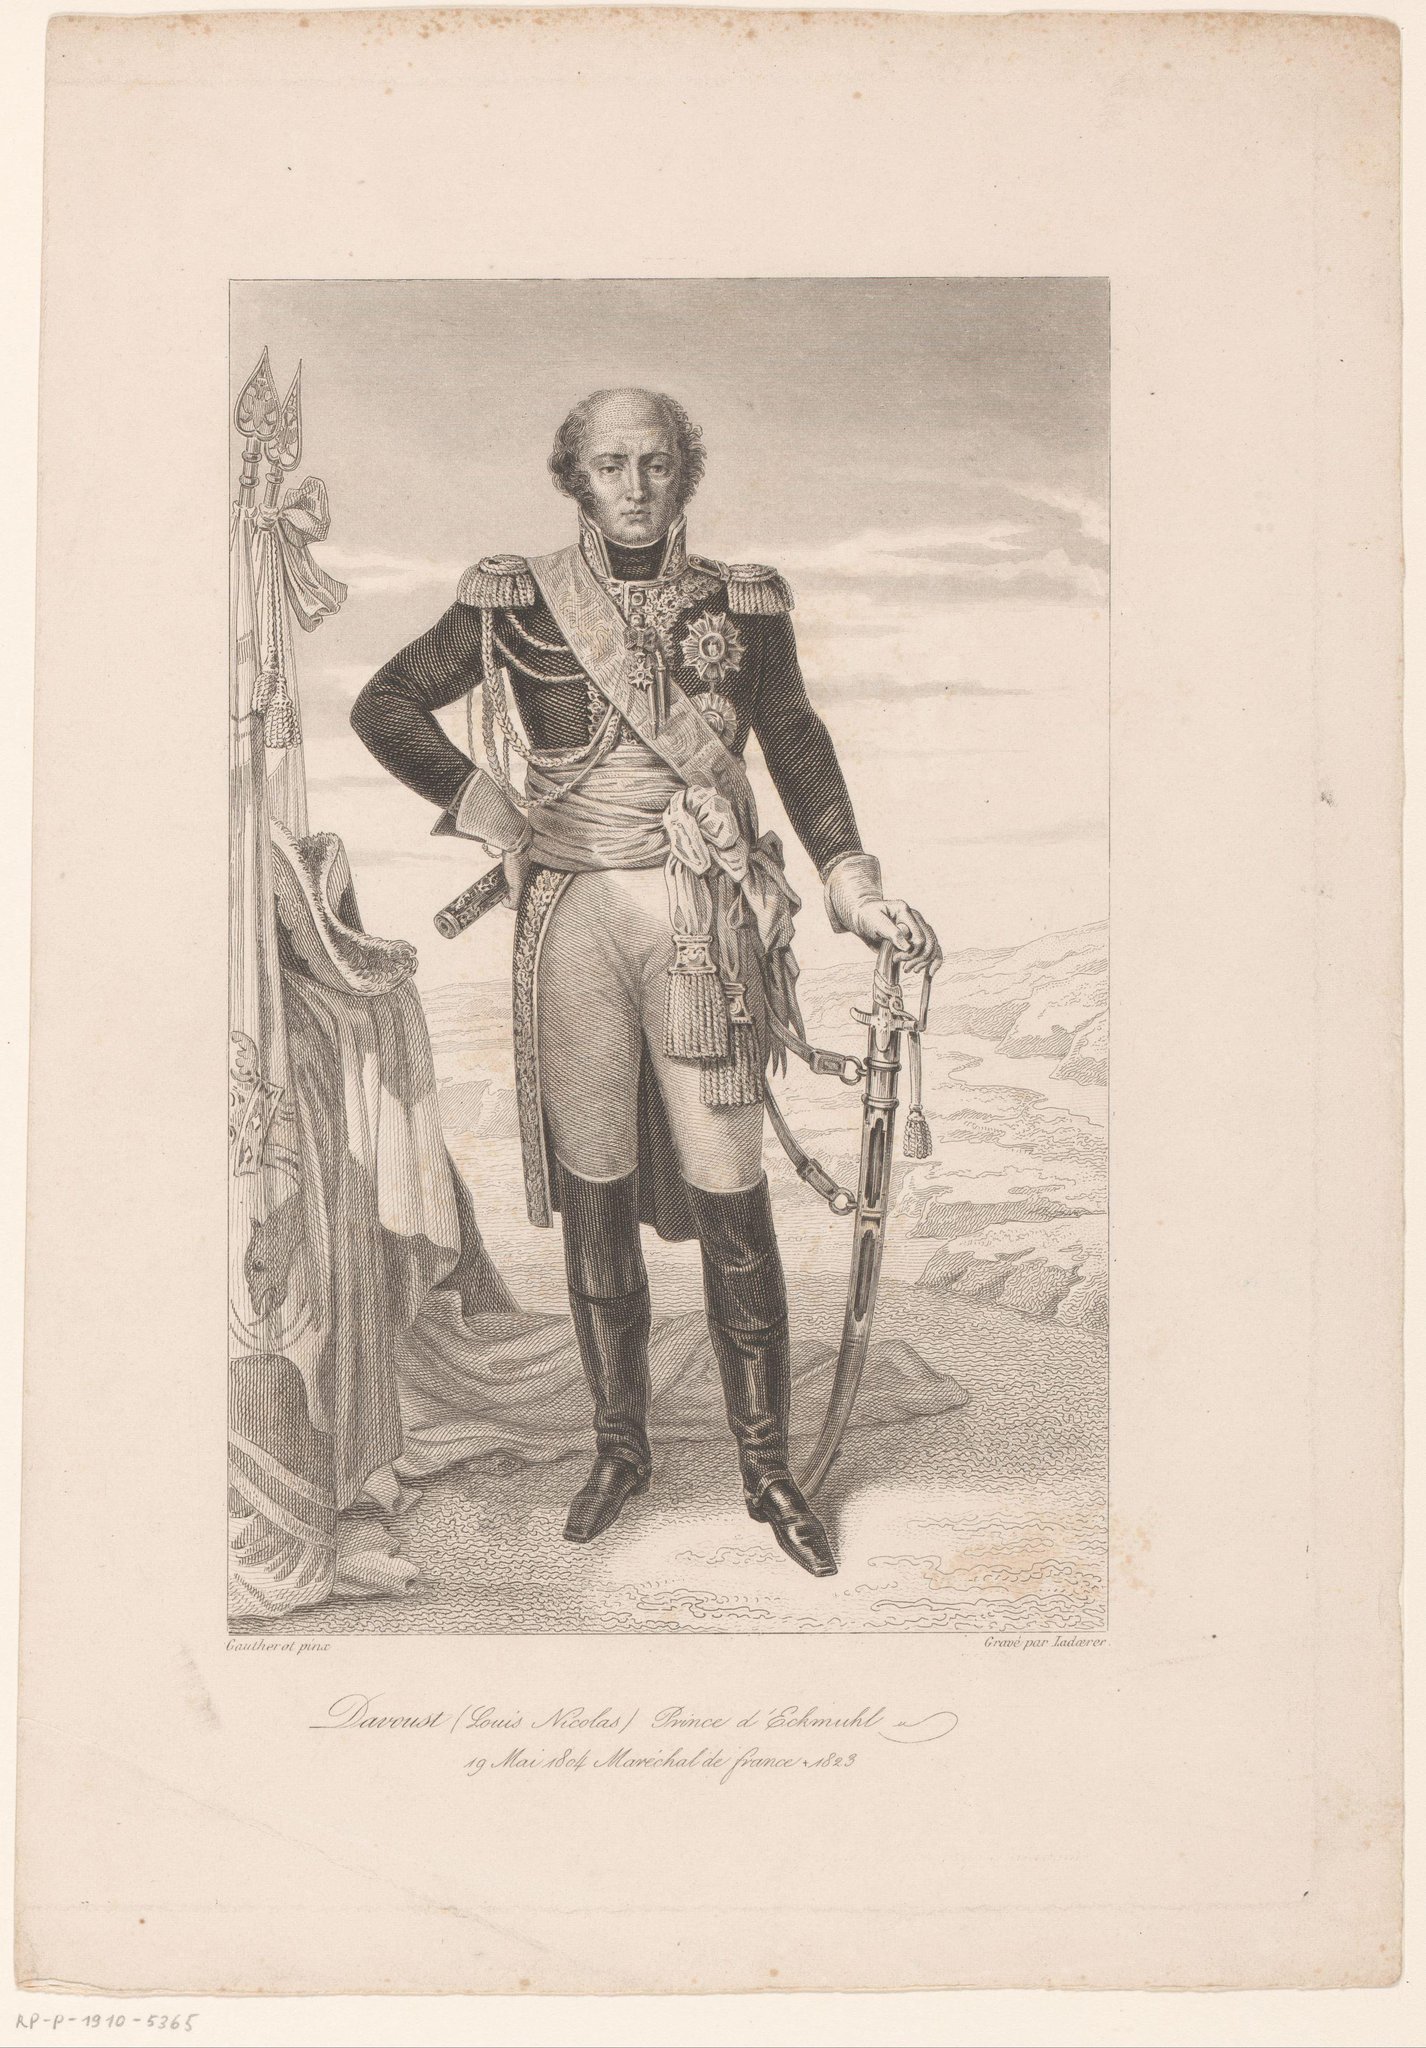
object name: print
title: Portret van Louis-Nicolas Davout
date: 1838-1841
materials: paper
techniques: engraving, etching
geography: paris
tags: paris, commander-in-chief, general, marshal, historical persons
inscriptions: collector's mark: Lugt 2228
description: Prent uit: Galeries historiques de Versailles. Parijs: Charles Gavard, 1838-1841.